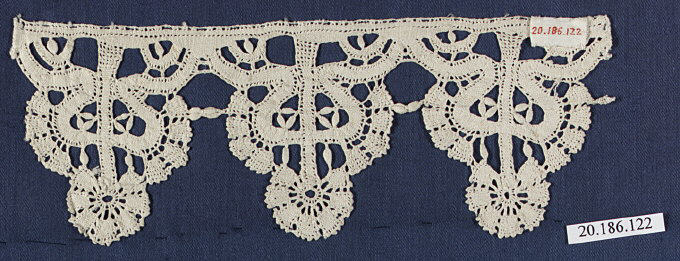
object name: edging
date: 1601-1700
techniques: lace